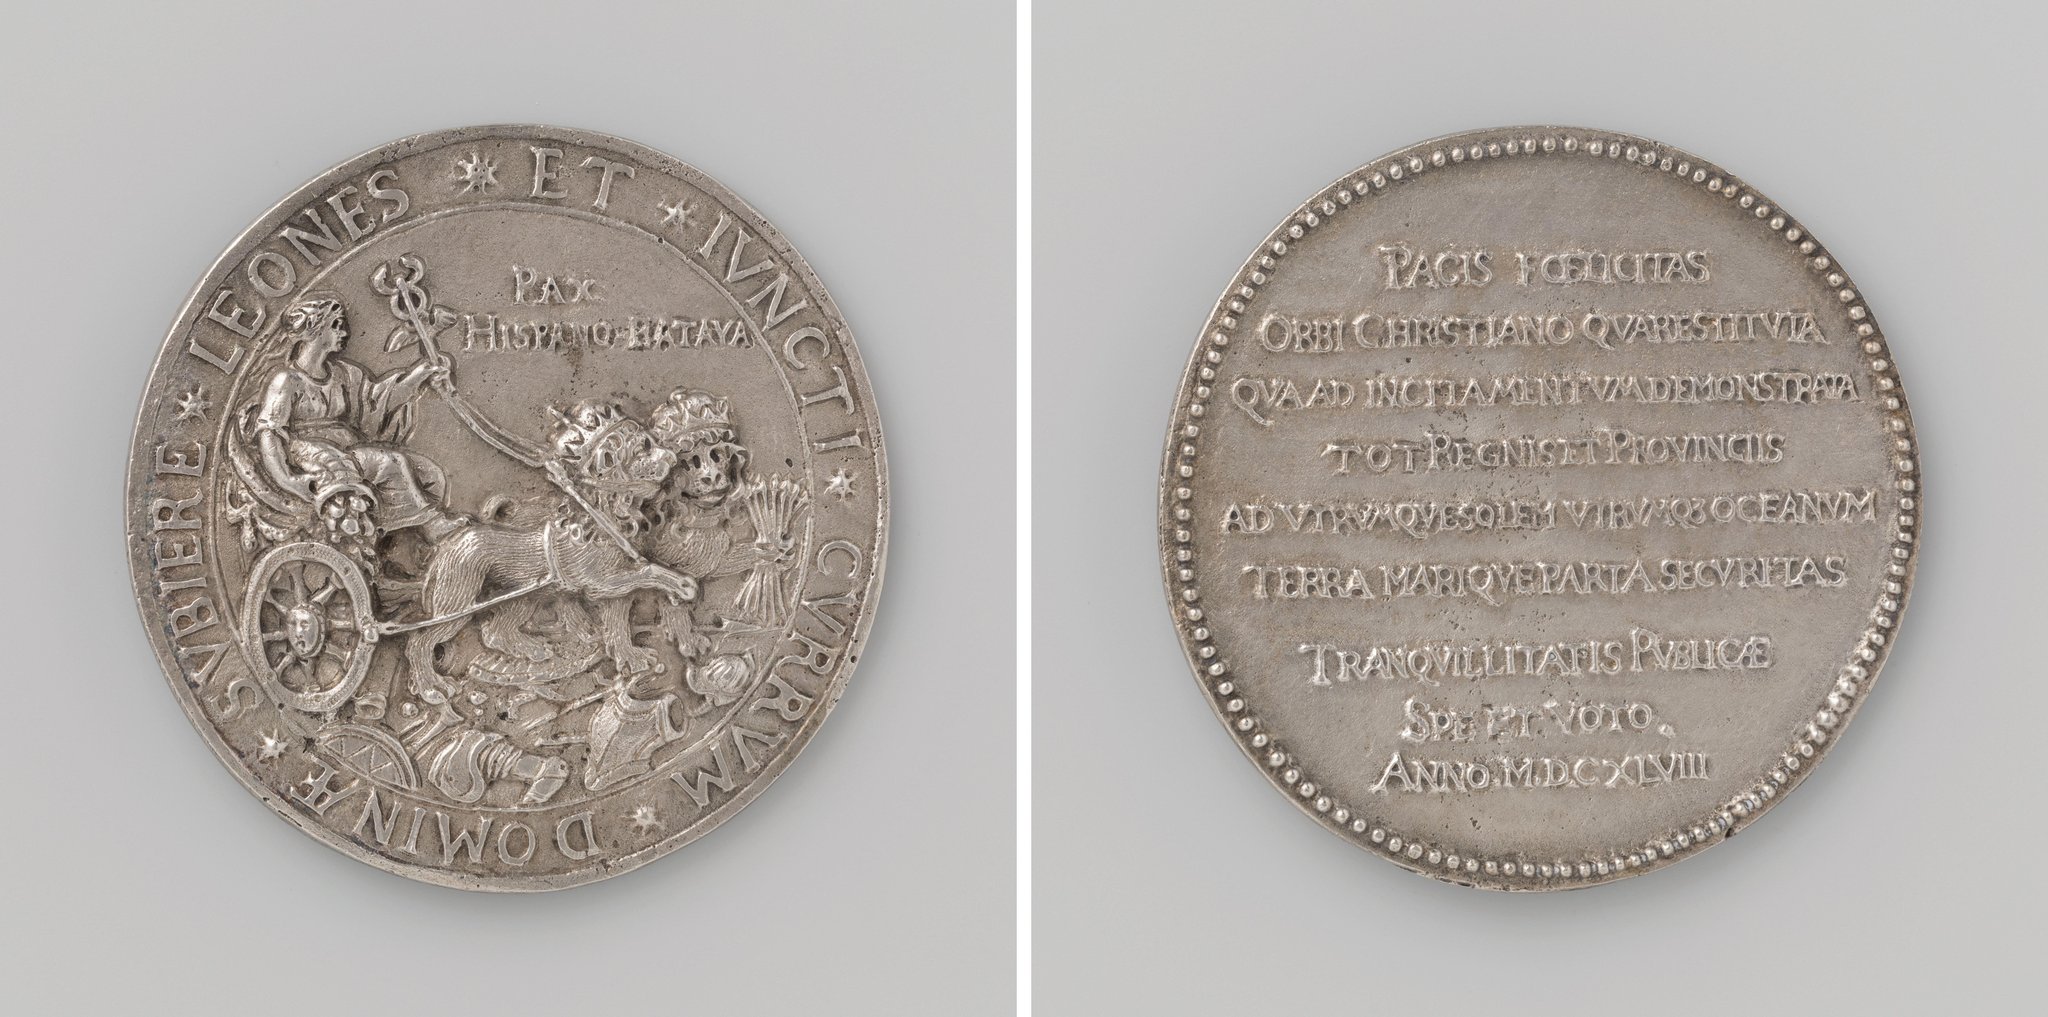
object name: medal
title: Penning over de Vrede van Munster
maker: Anonymous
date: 1648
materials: lead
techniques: striking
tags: münster, noordrijn-westfalen, vrede van münster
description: Loden penning. Voorzijde: Vrede met Mercuriusstaf en hoorn van overvloed op zegewagen getrokken door twee gekroonde leeuwen onder opschrift binnen omschrift. Keerzijde: opschrift.